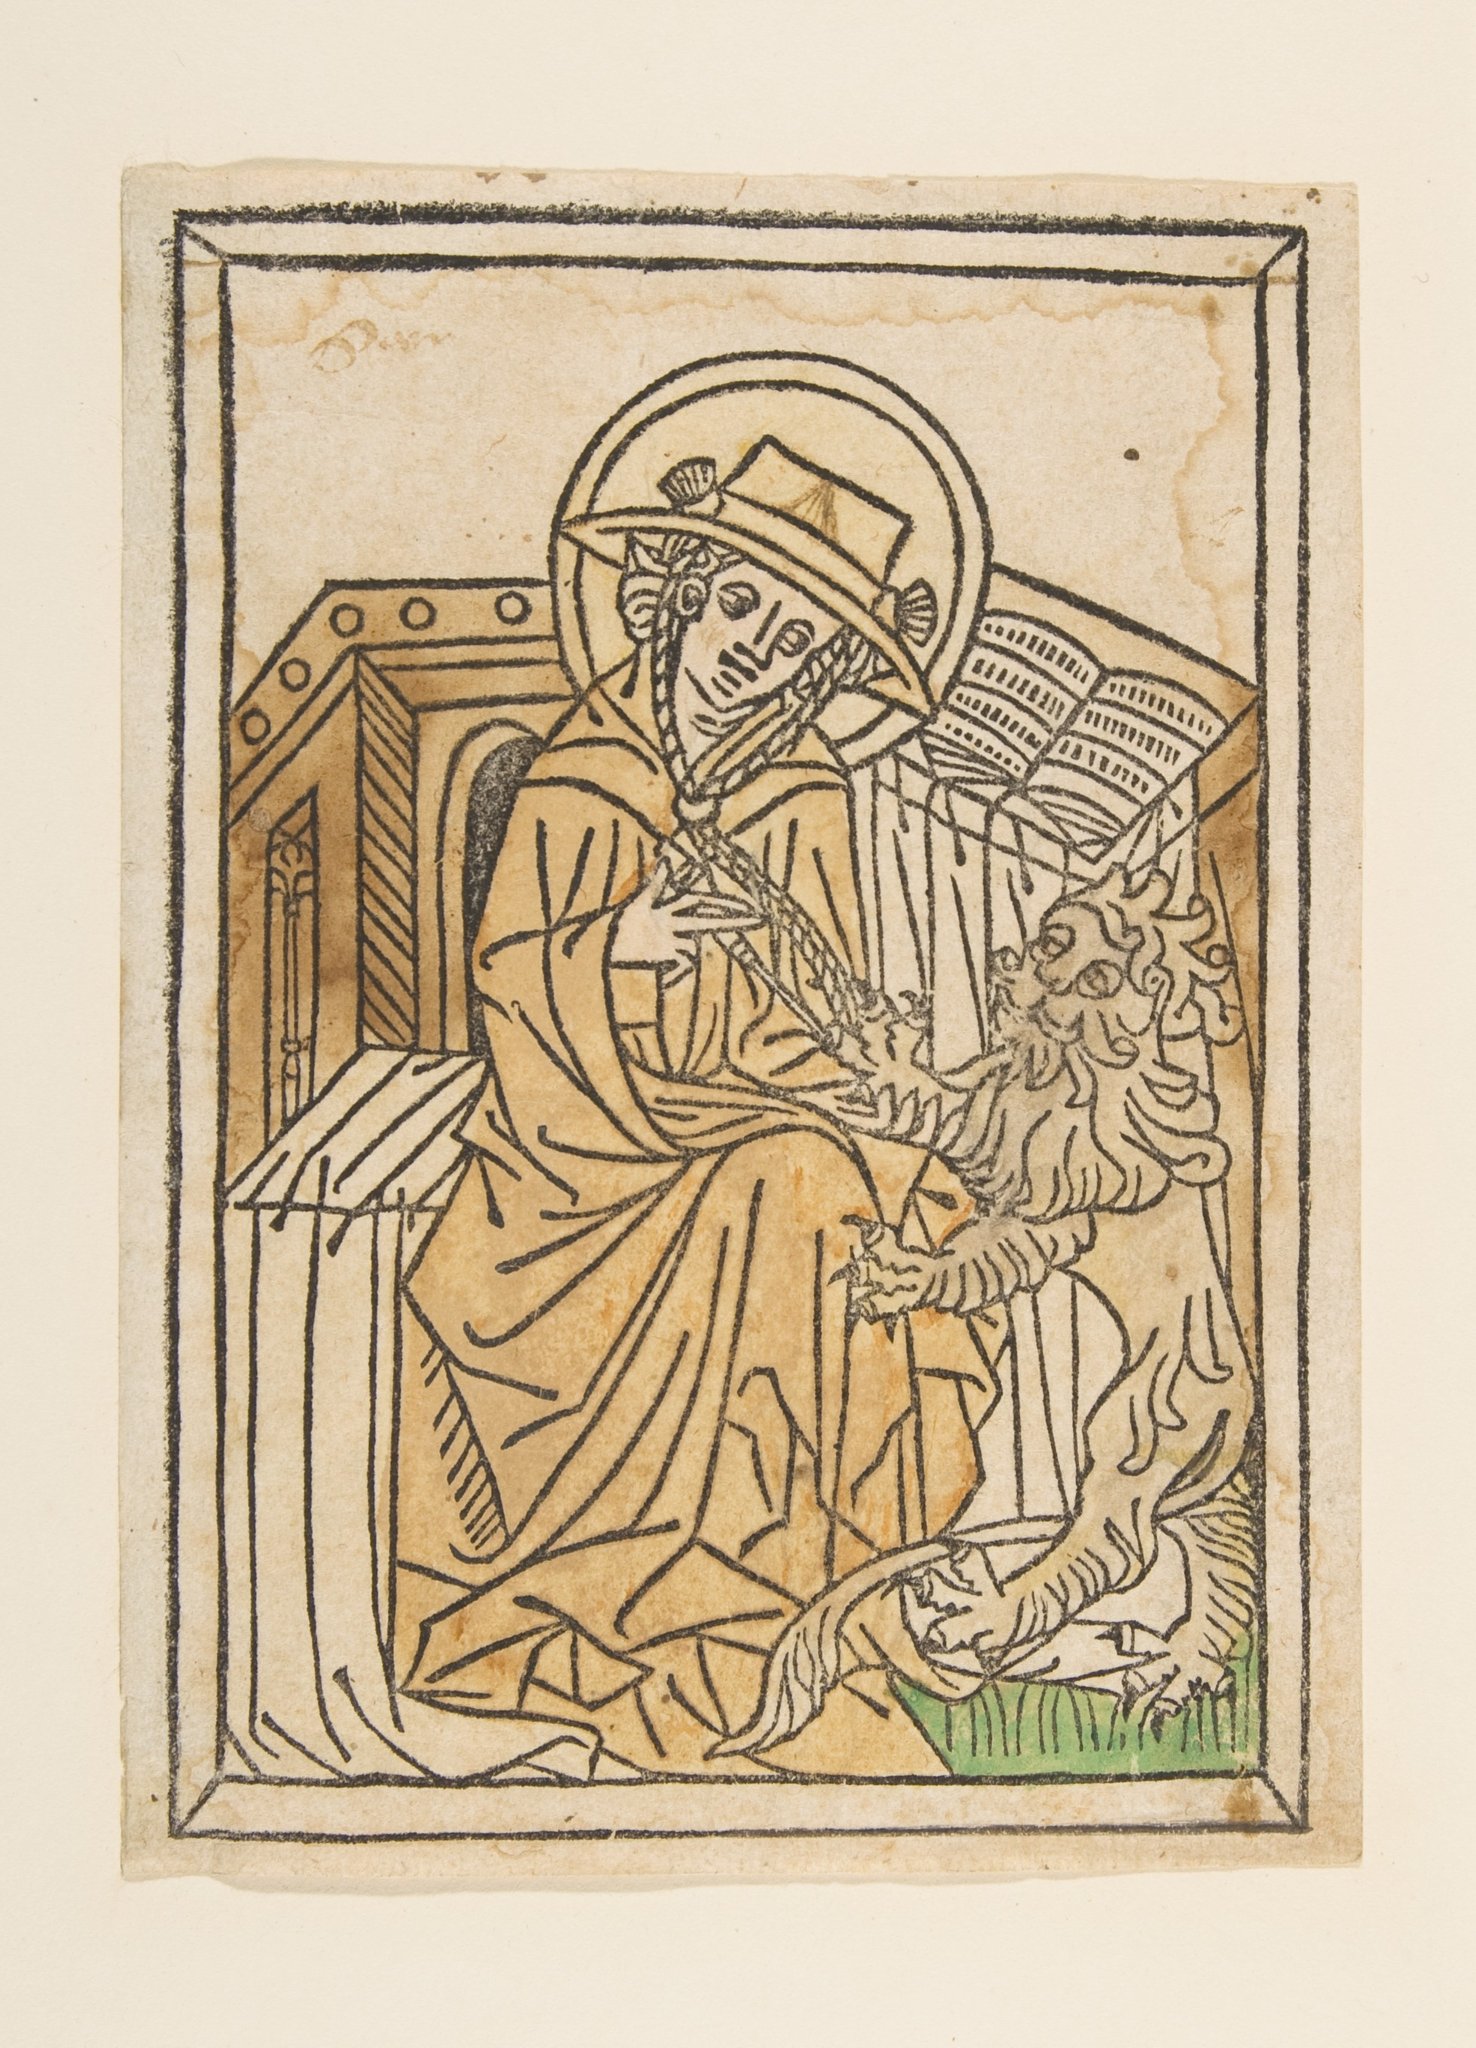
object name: print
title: St. Jerome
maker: anonymous, german, 15th century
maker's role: artist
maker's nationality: german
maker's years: 1400-1500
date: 1401-1500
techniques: hand coloring, woodcut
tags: lions,saint jerome